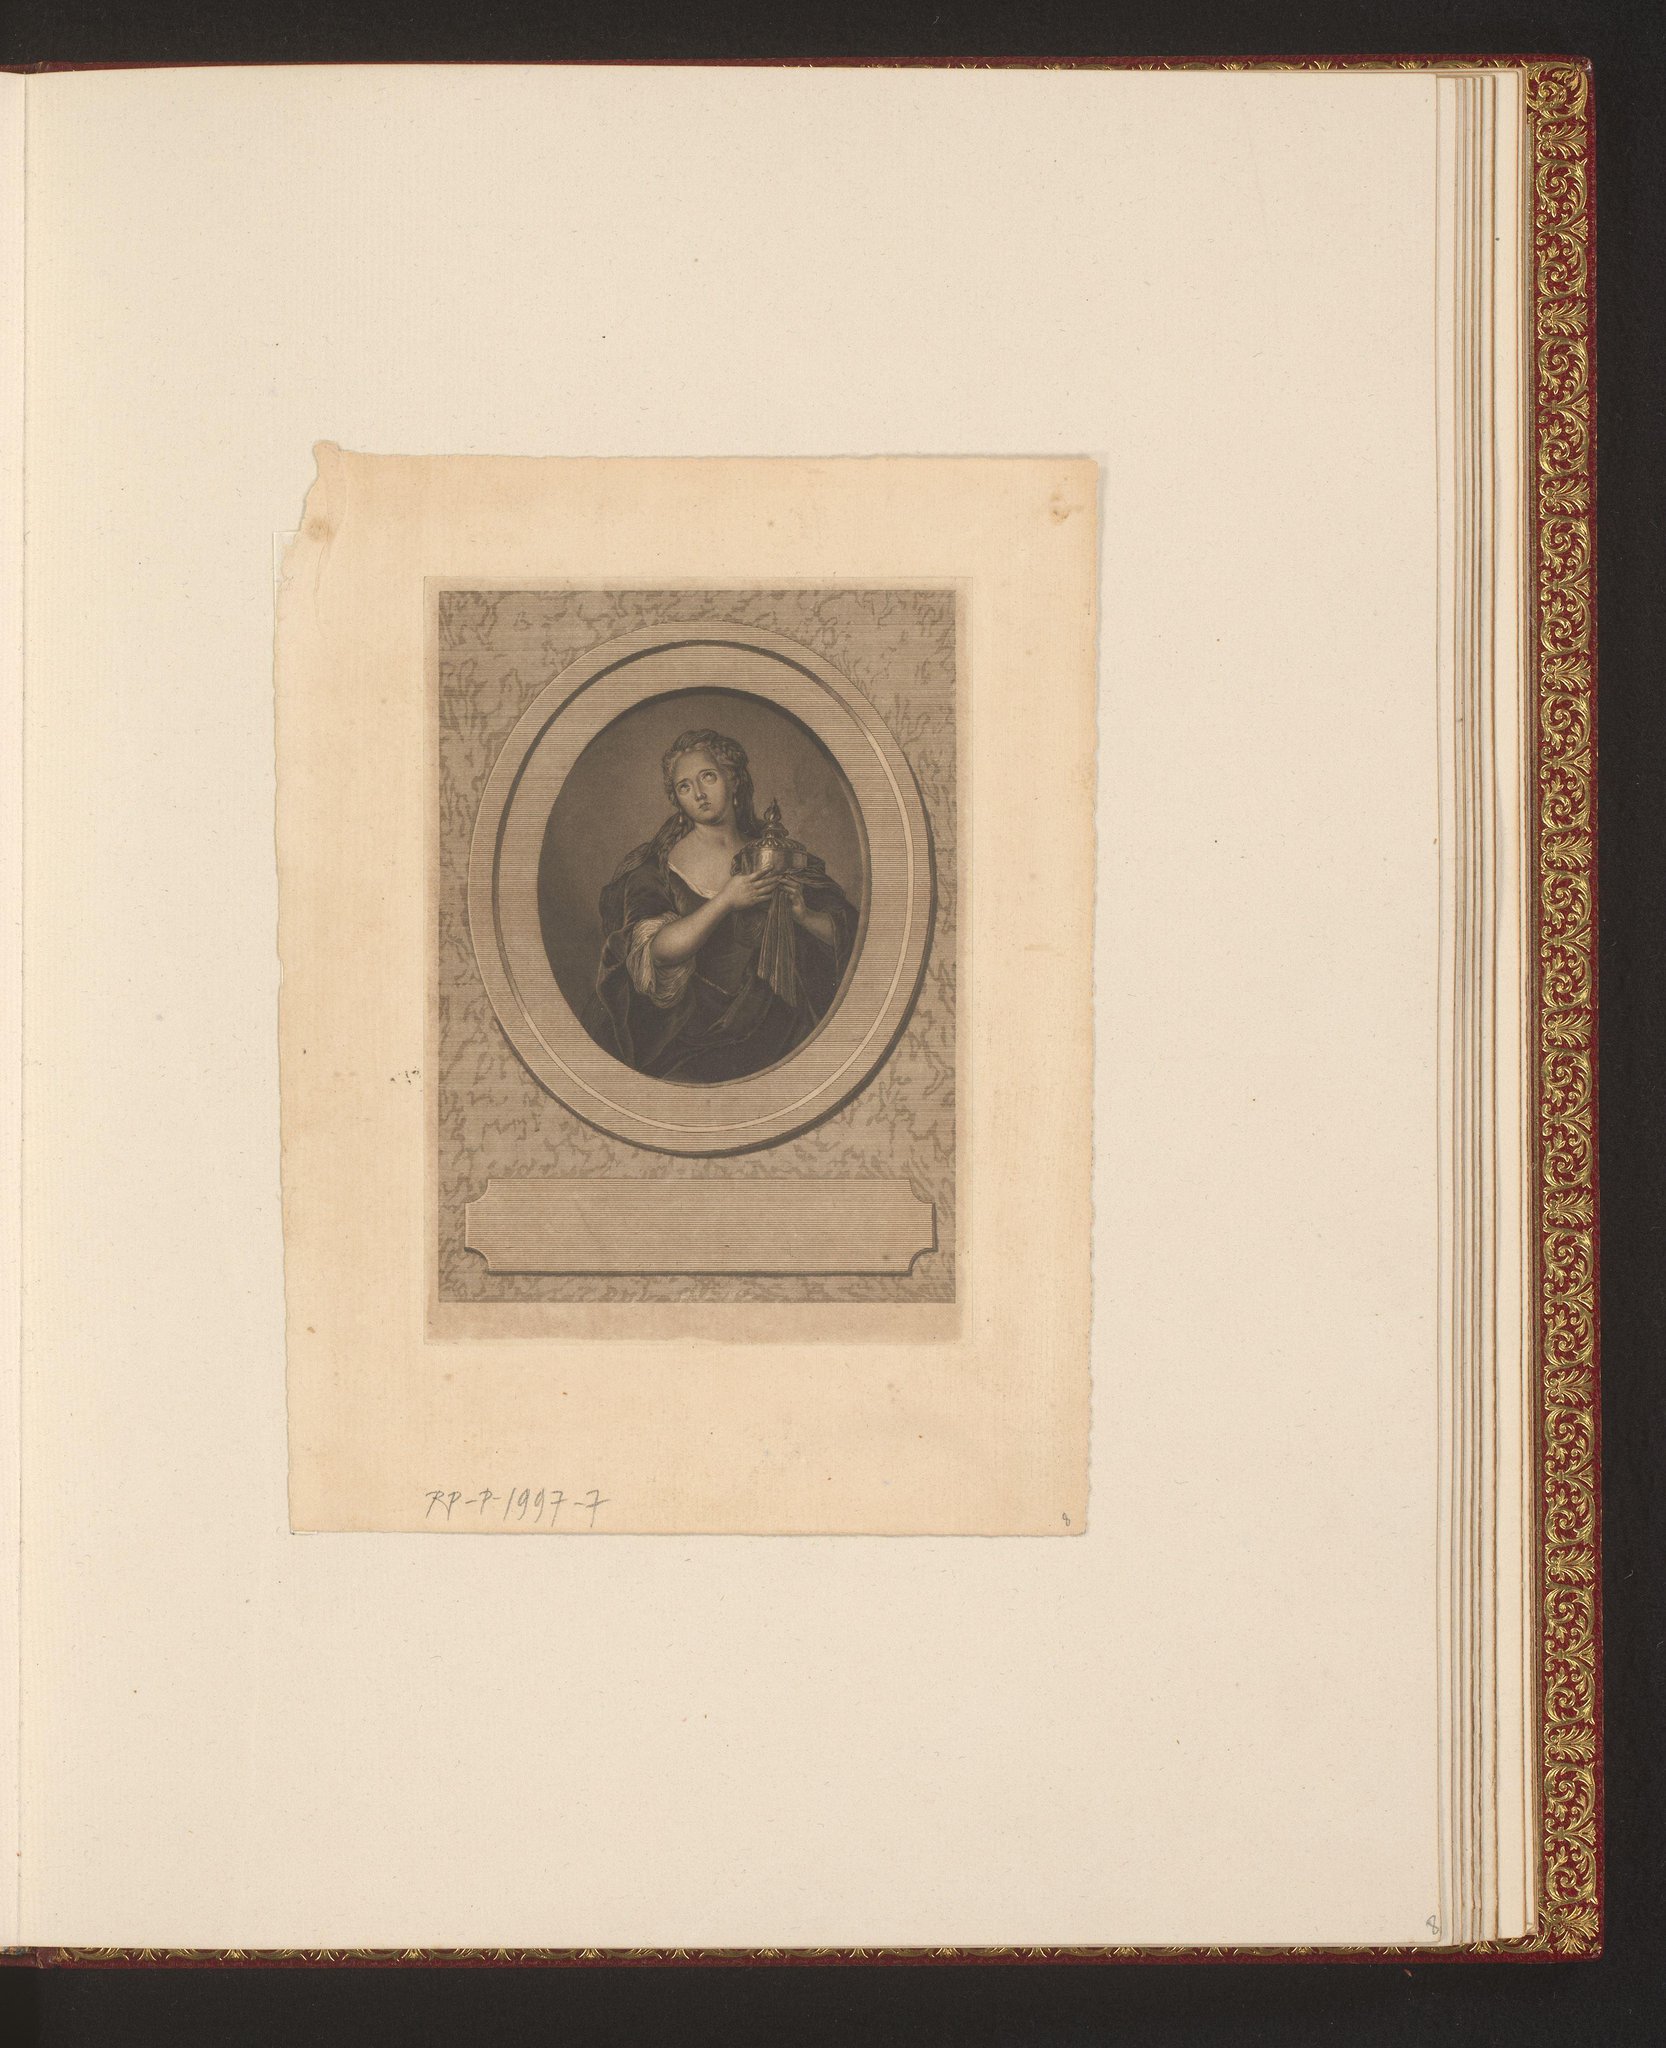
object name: album leaf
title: Portret van Adrienne Lecouvreur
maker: jean-baptiste de grateloup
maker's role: painter, print maker, sculptor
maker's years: 1735-1817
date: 1768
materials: paper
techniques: aquatint, etching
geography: france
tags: paris, historical persons - bb - woman, portrait of actor, actress, urn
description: Portret van de toneelspeelster Adrienne Lecouvreur als Cornelia in Pierre Corneille’s "De dood van Pompei". In haar handen een urn met de as van haar man Pompeus. Deze prent maakt deel uit van een album.